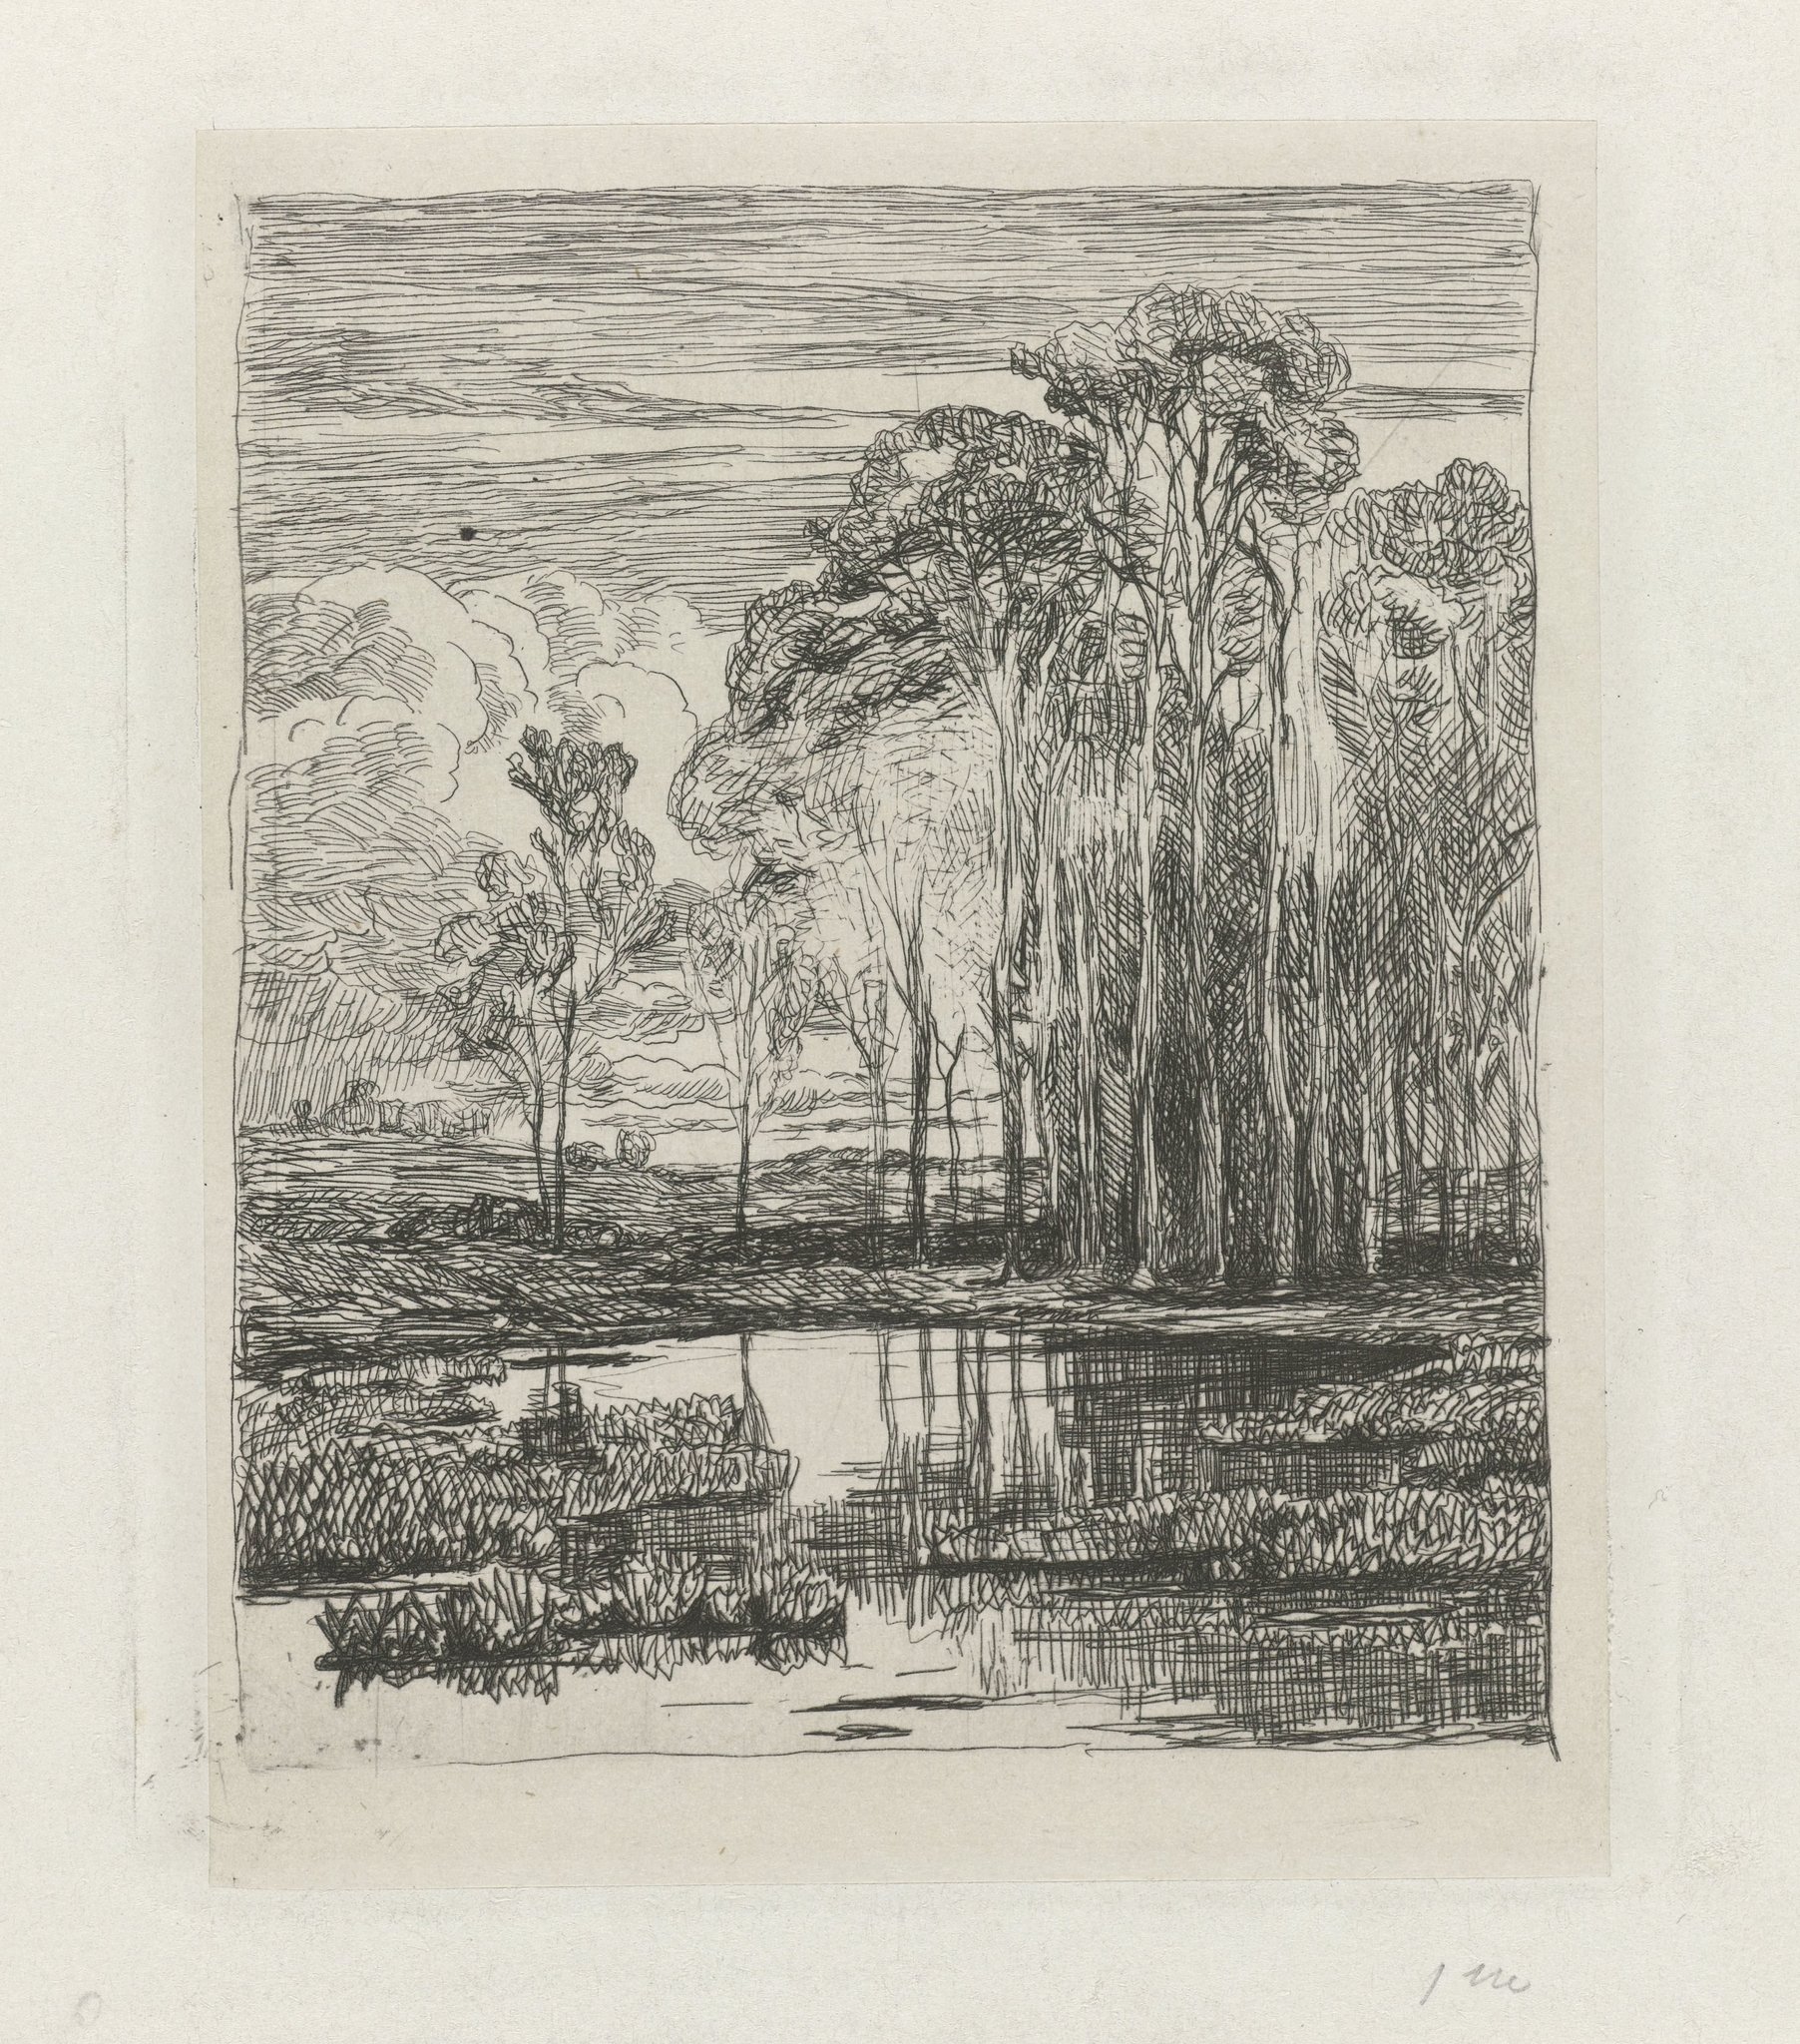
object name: print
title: Populieren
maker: willem roelofs (i)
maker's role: draughtsman, painter, print maker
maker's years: 1822-1897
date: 1832-1893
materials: paper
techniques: drypoint, etching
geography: netherlands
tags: landscapes, trees: poplar, pond, pool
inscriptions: collector's mark: Lugt 2228, inscription: ‘[...] WRF in de [...]’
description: Landschap met enkele populieren aan de rand van een waterplas. In het water is een reflectie van de bomen te zien.